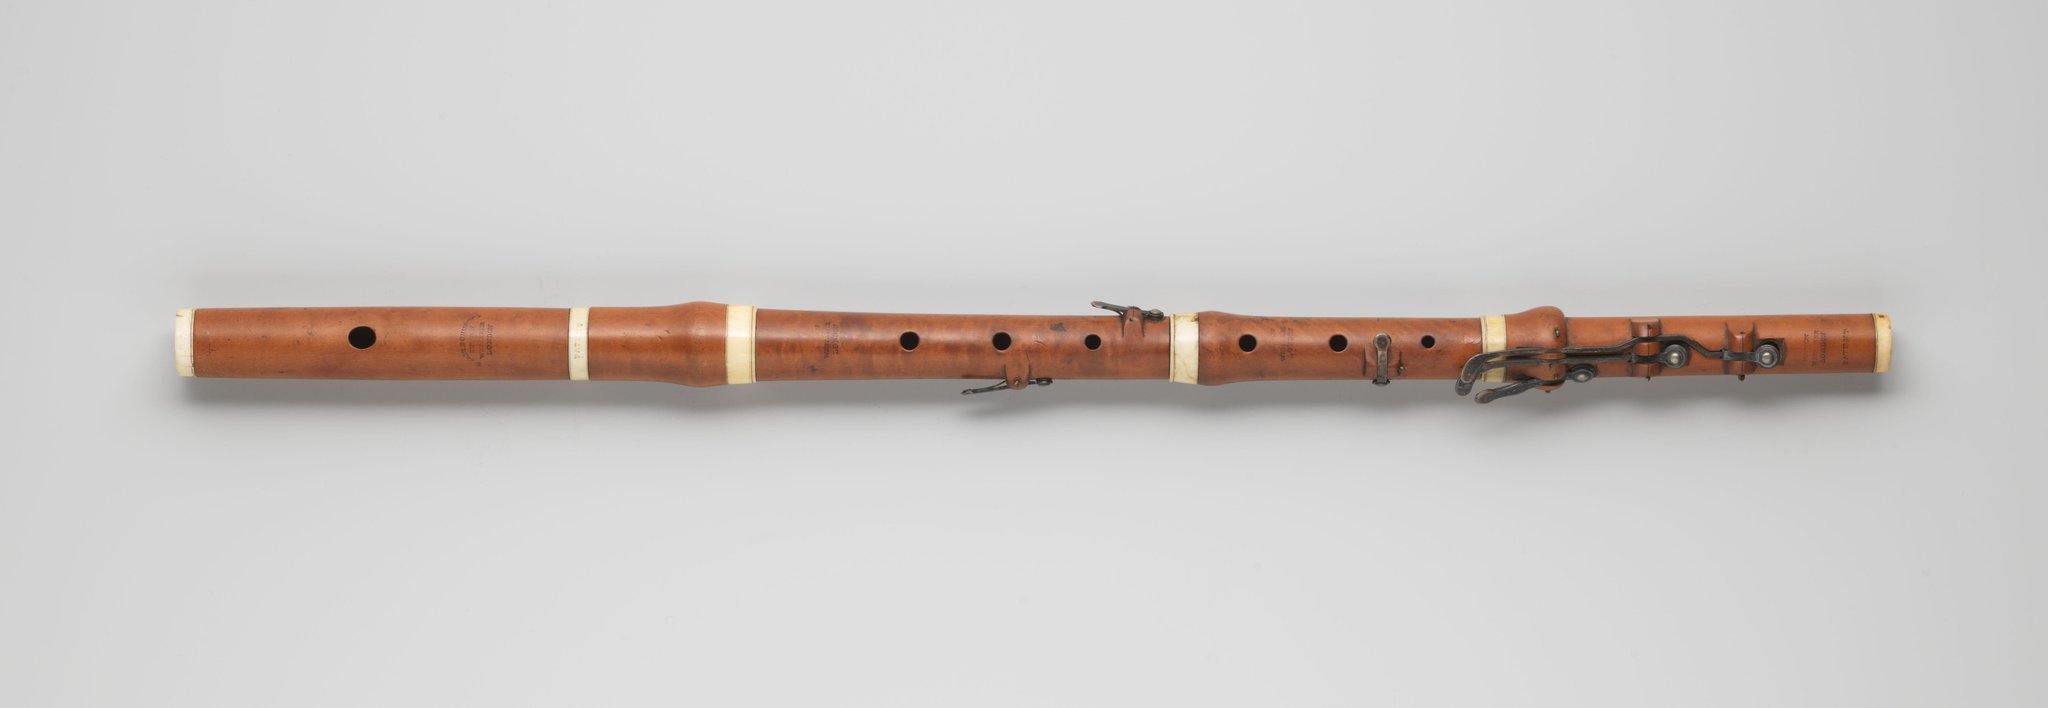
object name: wind instrument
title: Flute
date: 1808-1814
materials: wood, brass, ivory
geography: london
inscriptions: stamp: ‘Button and Whittaker’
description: Dwarsfluit van buxushout met ivoren ringen en zes messing kleppen. De kop bestaat uit twee delen, waarvan er één de stemschuif is. Stemming a= 450 Hz.